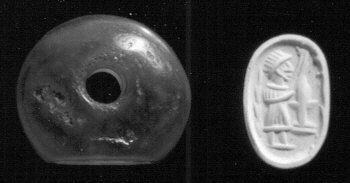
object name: stamp seal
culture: sasanian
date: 201-700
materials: stone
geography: iran or mesopotamia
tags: men